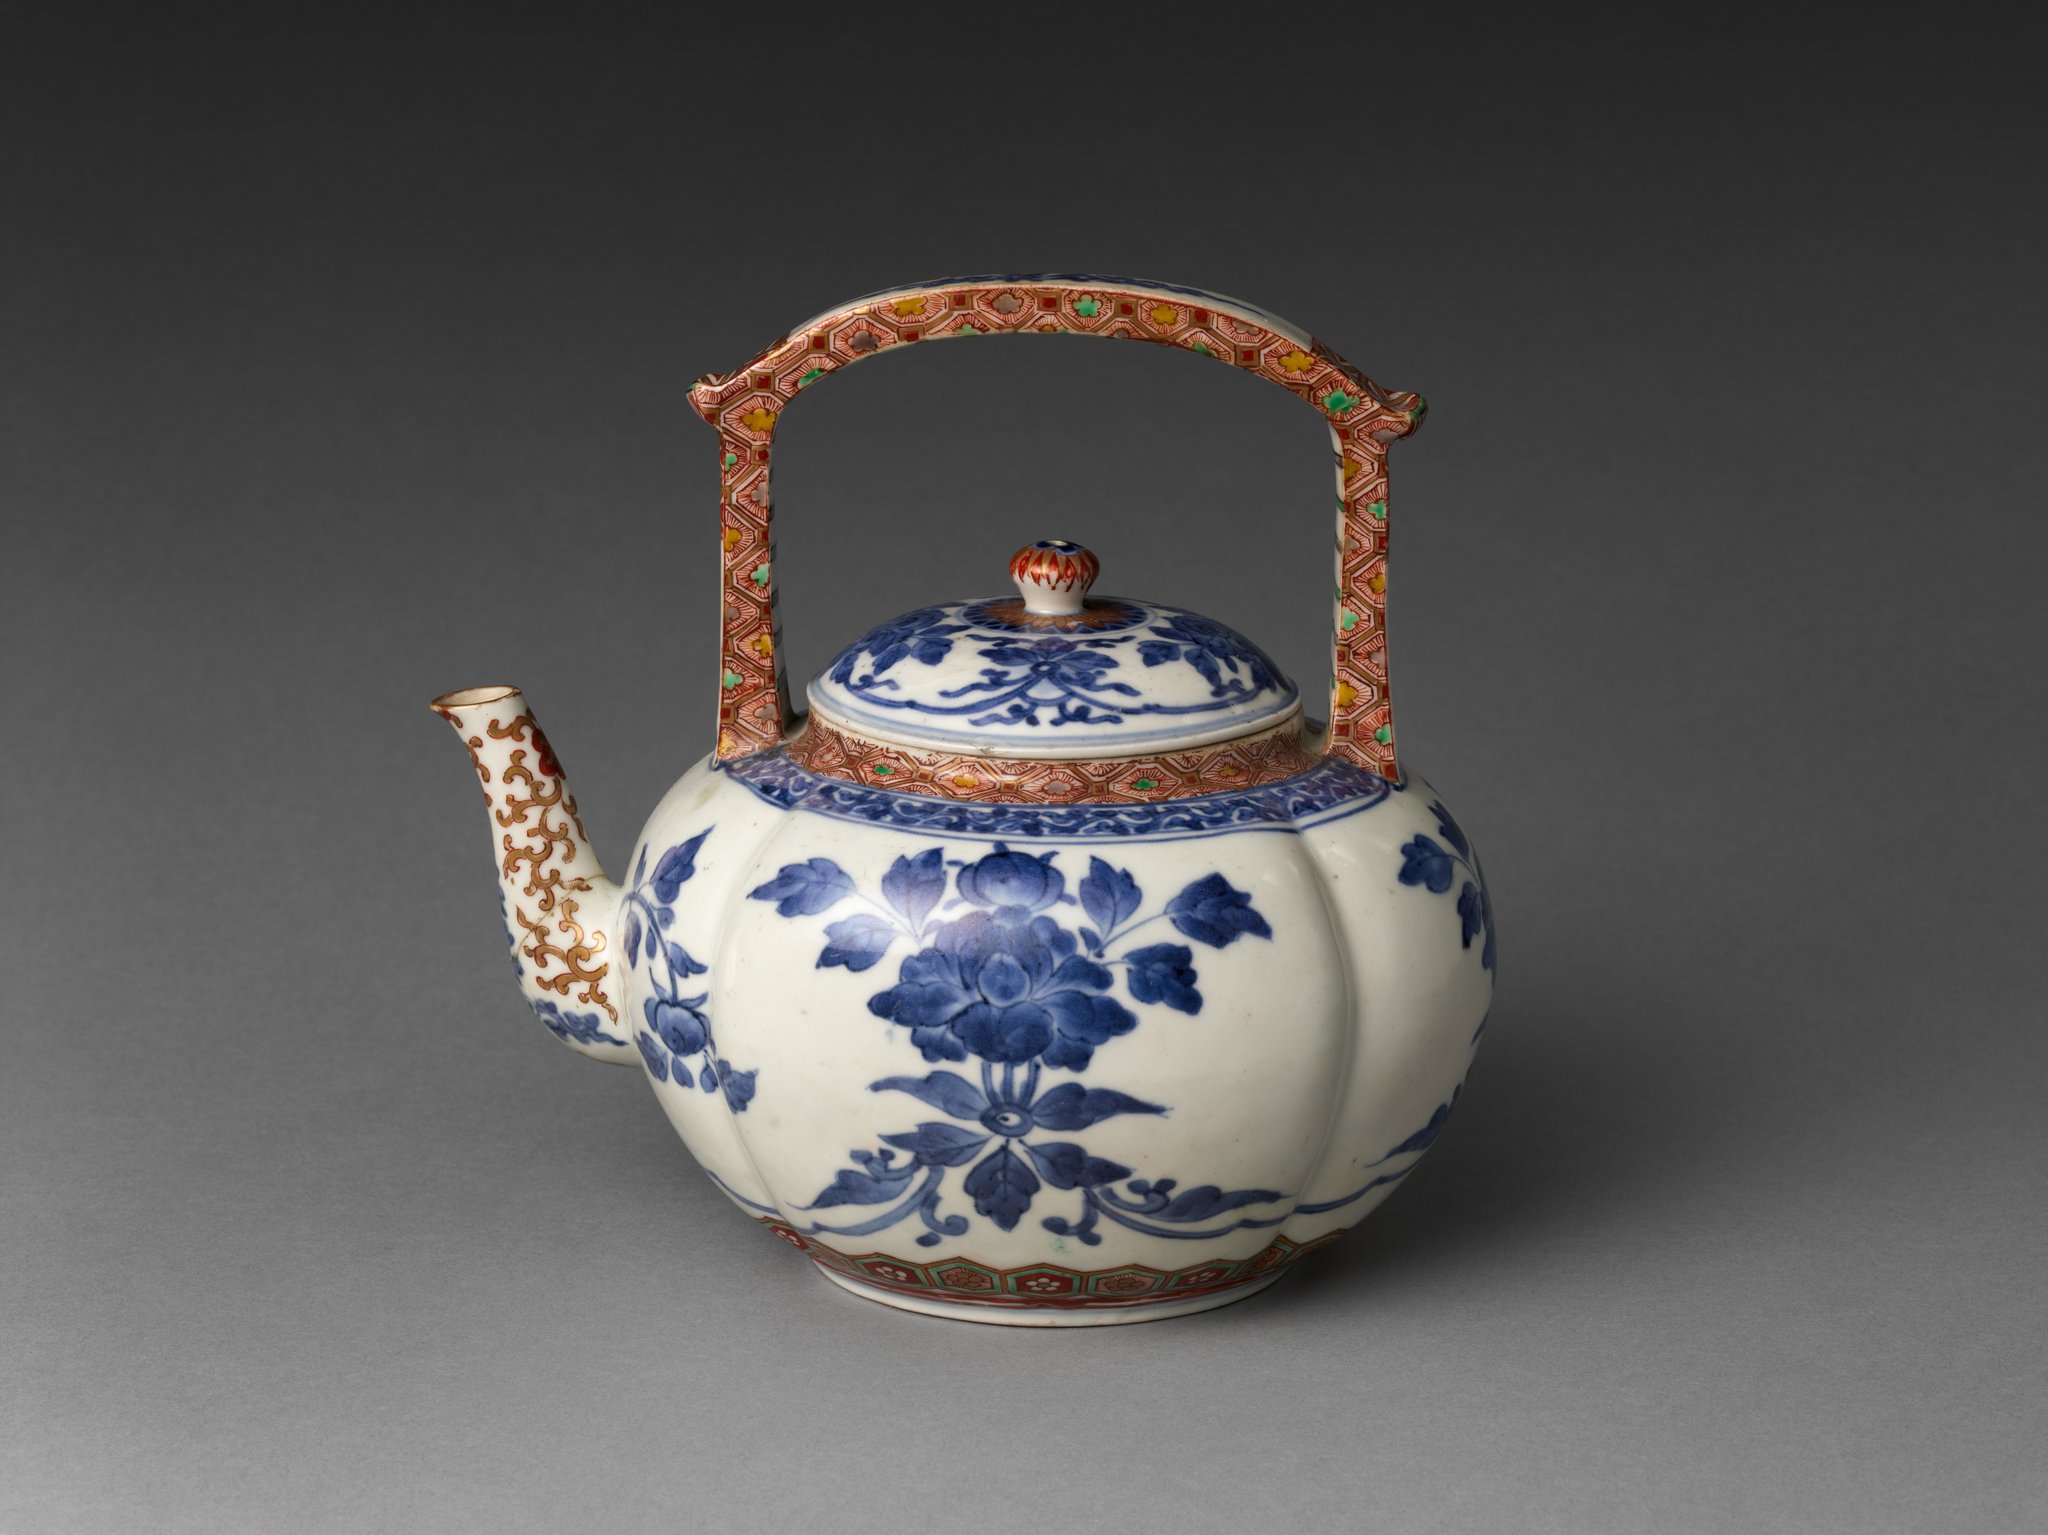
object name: teapot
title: Teapot in Melon Shape with Peonies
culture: japanese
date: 1700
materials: cobalt, enamel, glaze, porcelain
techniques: painting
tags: peonies